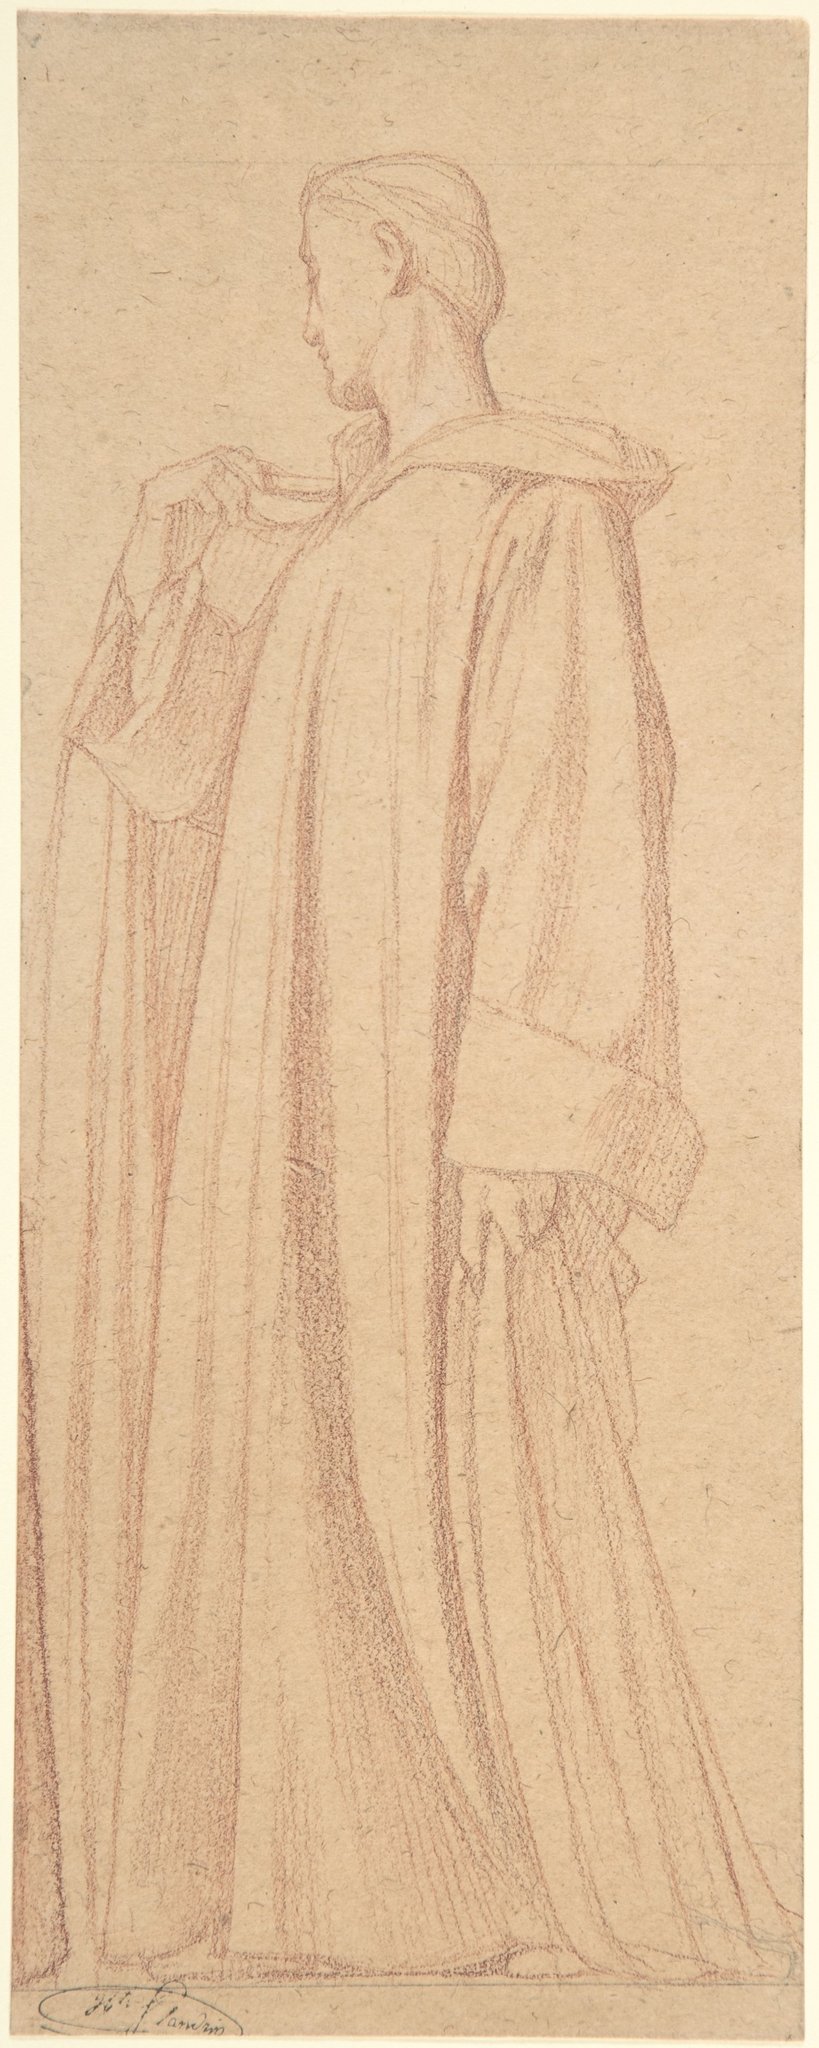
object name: drawing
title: Saint Cloud; Study for the frieze at Saint-Vincent-de-Paul, Paris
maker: hippolyte flandrin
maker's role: draftsman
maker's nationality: french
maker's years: 1809-1864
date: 1835-1864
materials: chalk, paper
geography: france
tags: men,saints